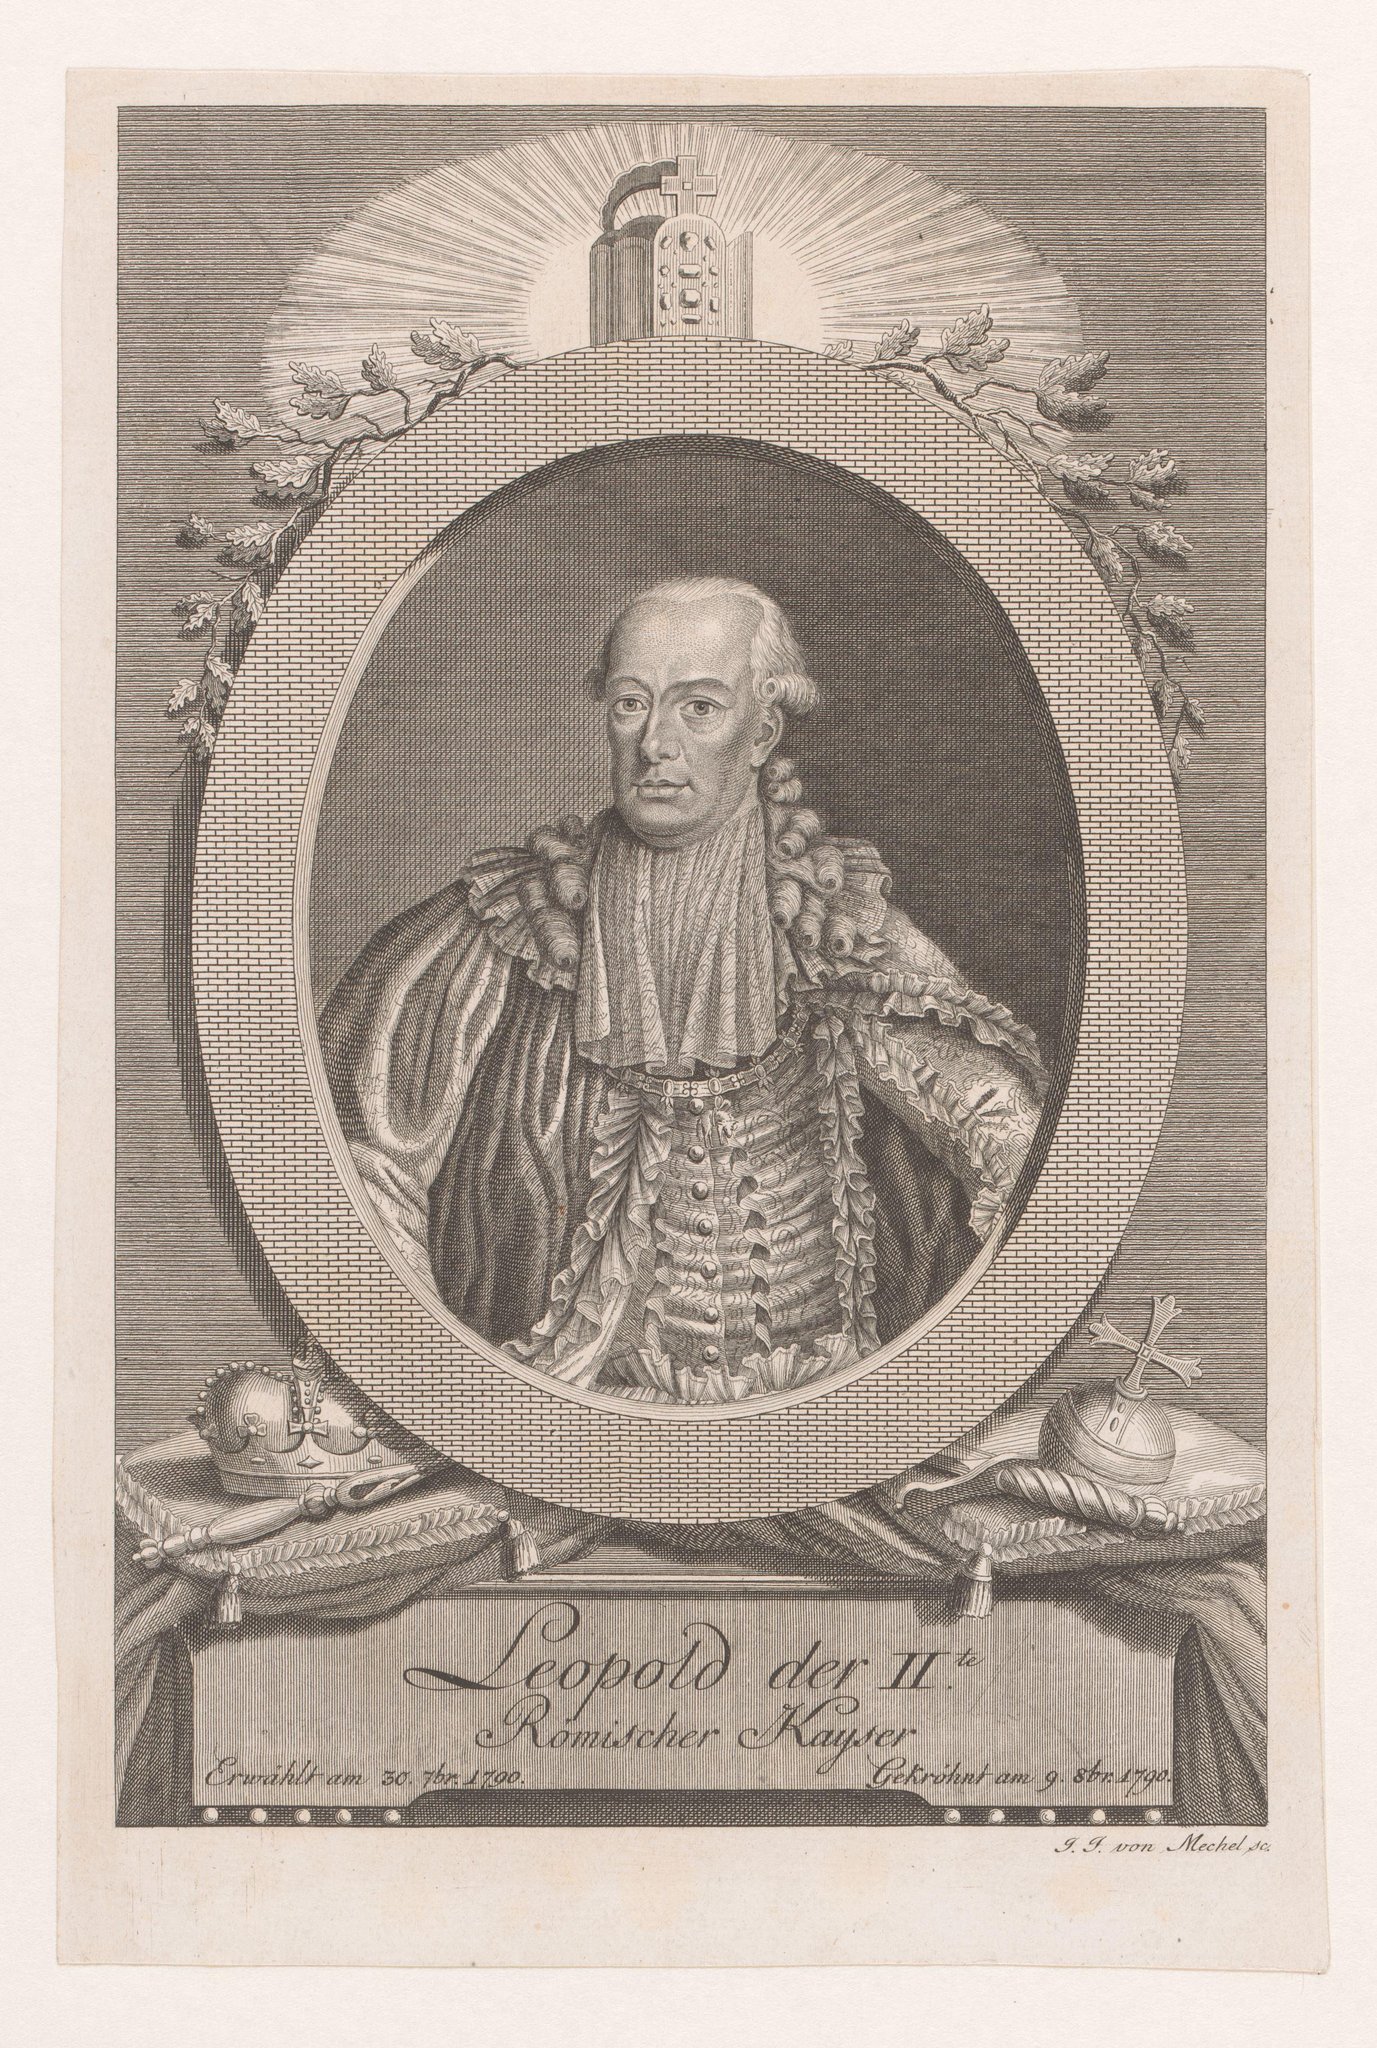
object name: print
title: Portret van keizer Leopold II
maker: johann jakob von mechel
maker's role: print maker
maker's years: 1764-1816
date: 1791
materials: paper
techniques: engraving, etching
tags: leopold ii (keizer van oostenrijk), orb (symbol of sovereignty; sphere with cross on top), rays as nimbus, emperor, insignia and symbols of sovereignty (crown, diadem, sceptre, orb, seal, standard, cloak, pectoral)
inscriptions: collector's mark: Lugt 2228